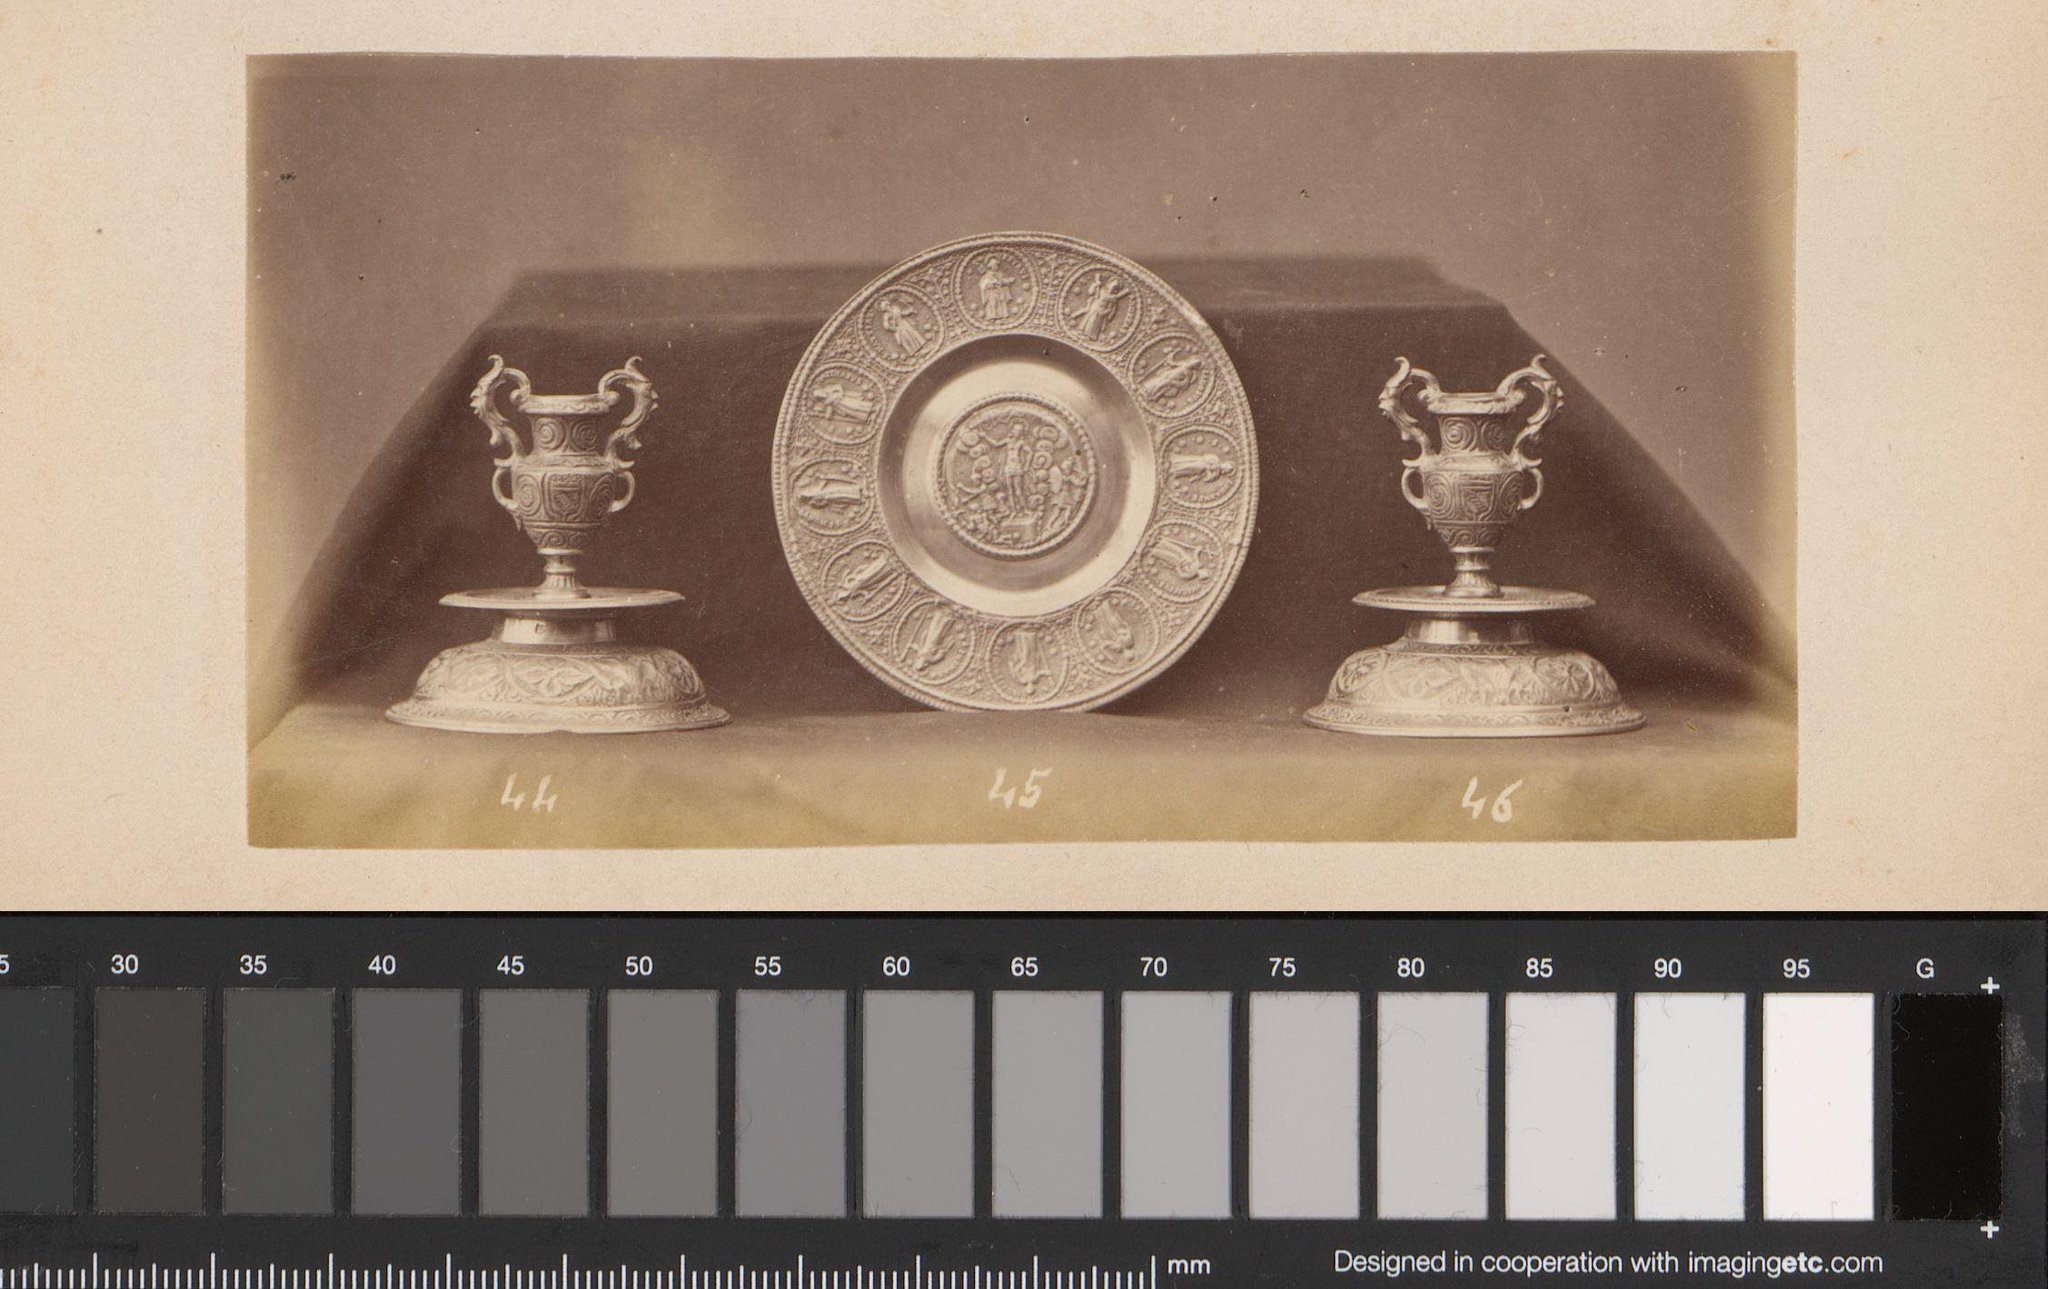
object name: page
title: Metalen kandelaars in Contarini model en een bord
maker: Anonymous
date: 1860-1885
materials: photographic support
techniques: albumen print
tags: dish, plate, saucer, candlestick